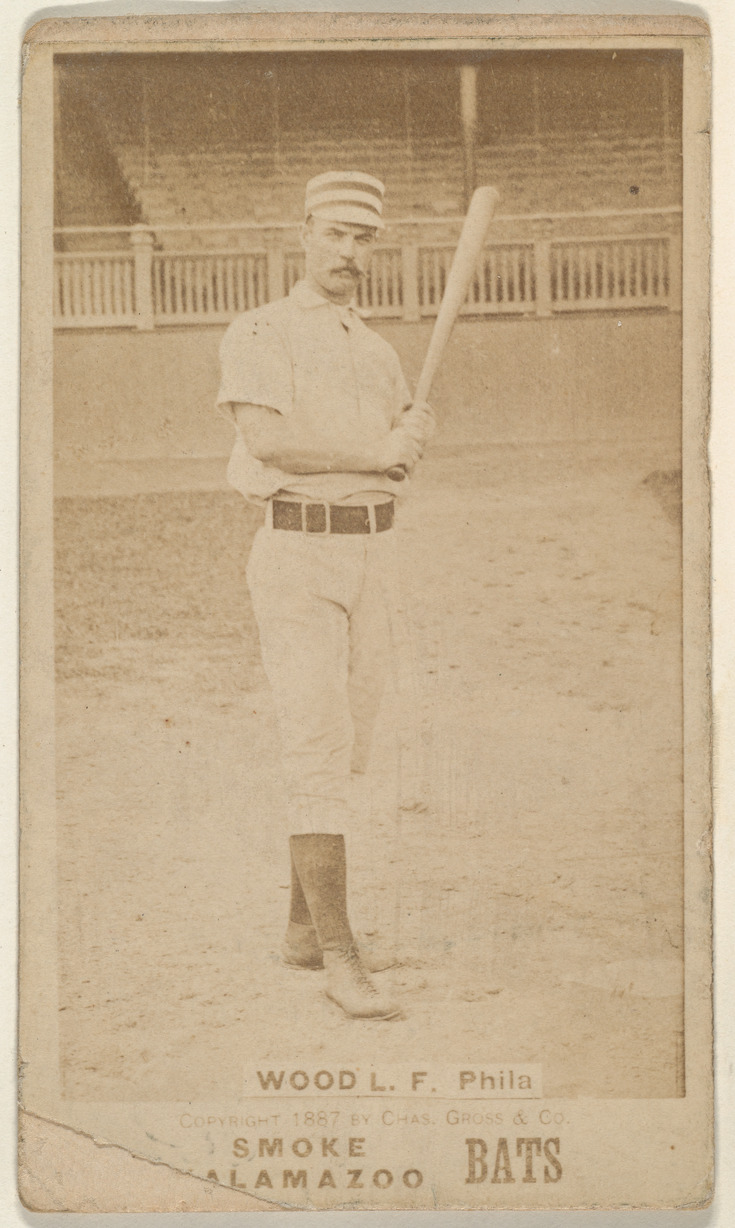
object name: baseball card, photograph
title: Wood, Left Field, Philadelphia, from the Kalamazoo Bats series (N690) issued by Chas. Gross & Co. to promote Kalamazoo Bats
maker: chas. gross & co.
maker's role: publisher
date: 1887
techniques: albumen silver print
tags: men,portraits,baseball,athletes